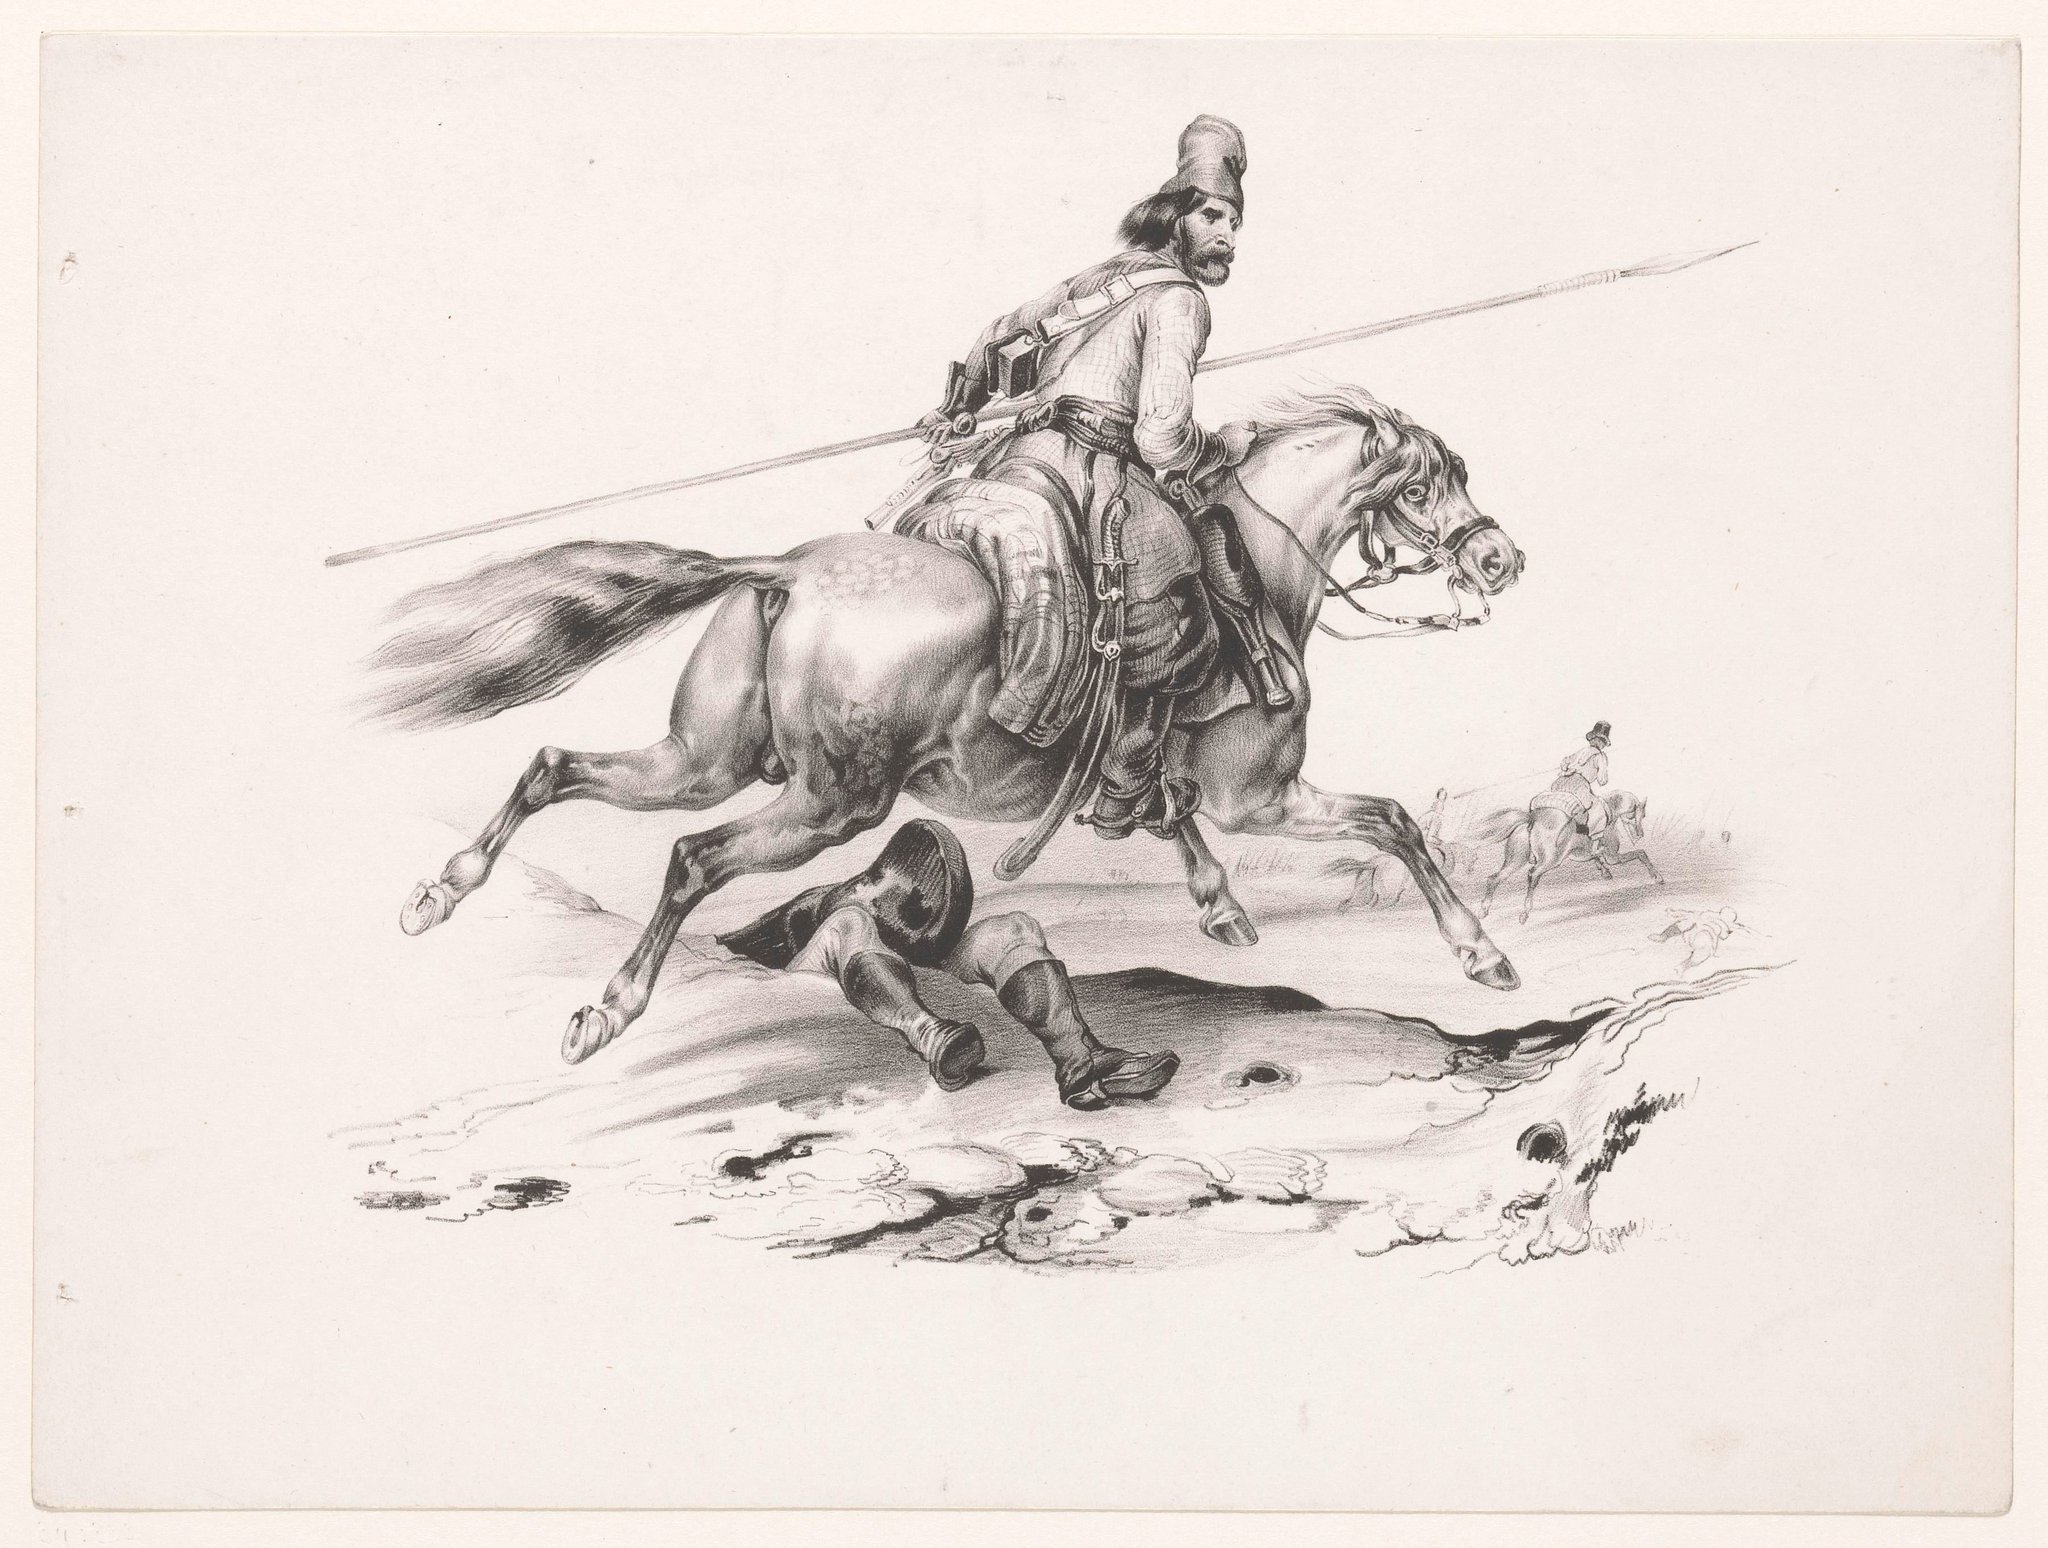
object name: print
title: Cheval cosaque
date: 1835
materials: paper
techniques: lithography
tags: riding a horse, ass, or mule; rider, horseman, galloping horse, the soldier; the soldier's life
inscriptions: collector's mark: Lugt 2228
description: In 1835 gaven Tessari en Aumont 101 bladen uit met paarden, met en zonder ruiters. De bladen werden uitgegeven als serie, maar ook los van elkaar.